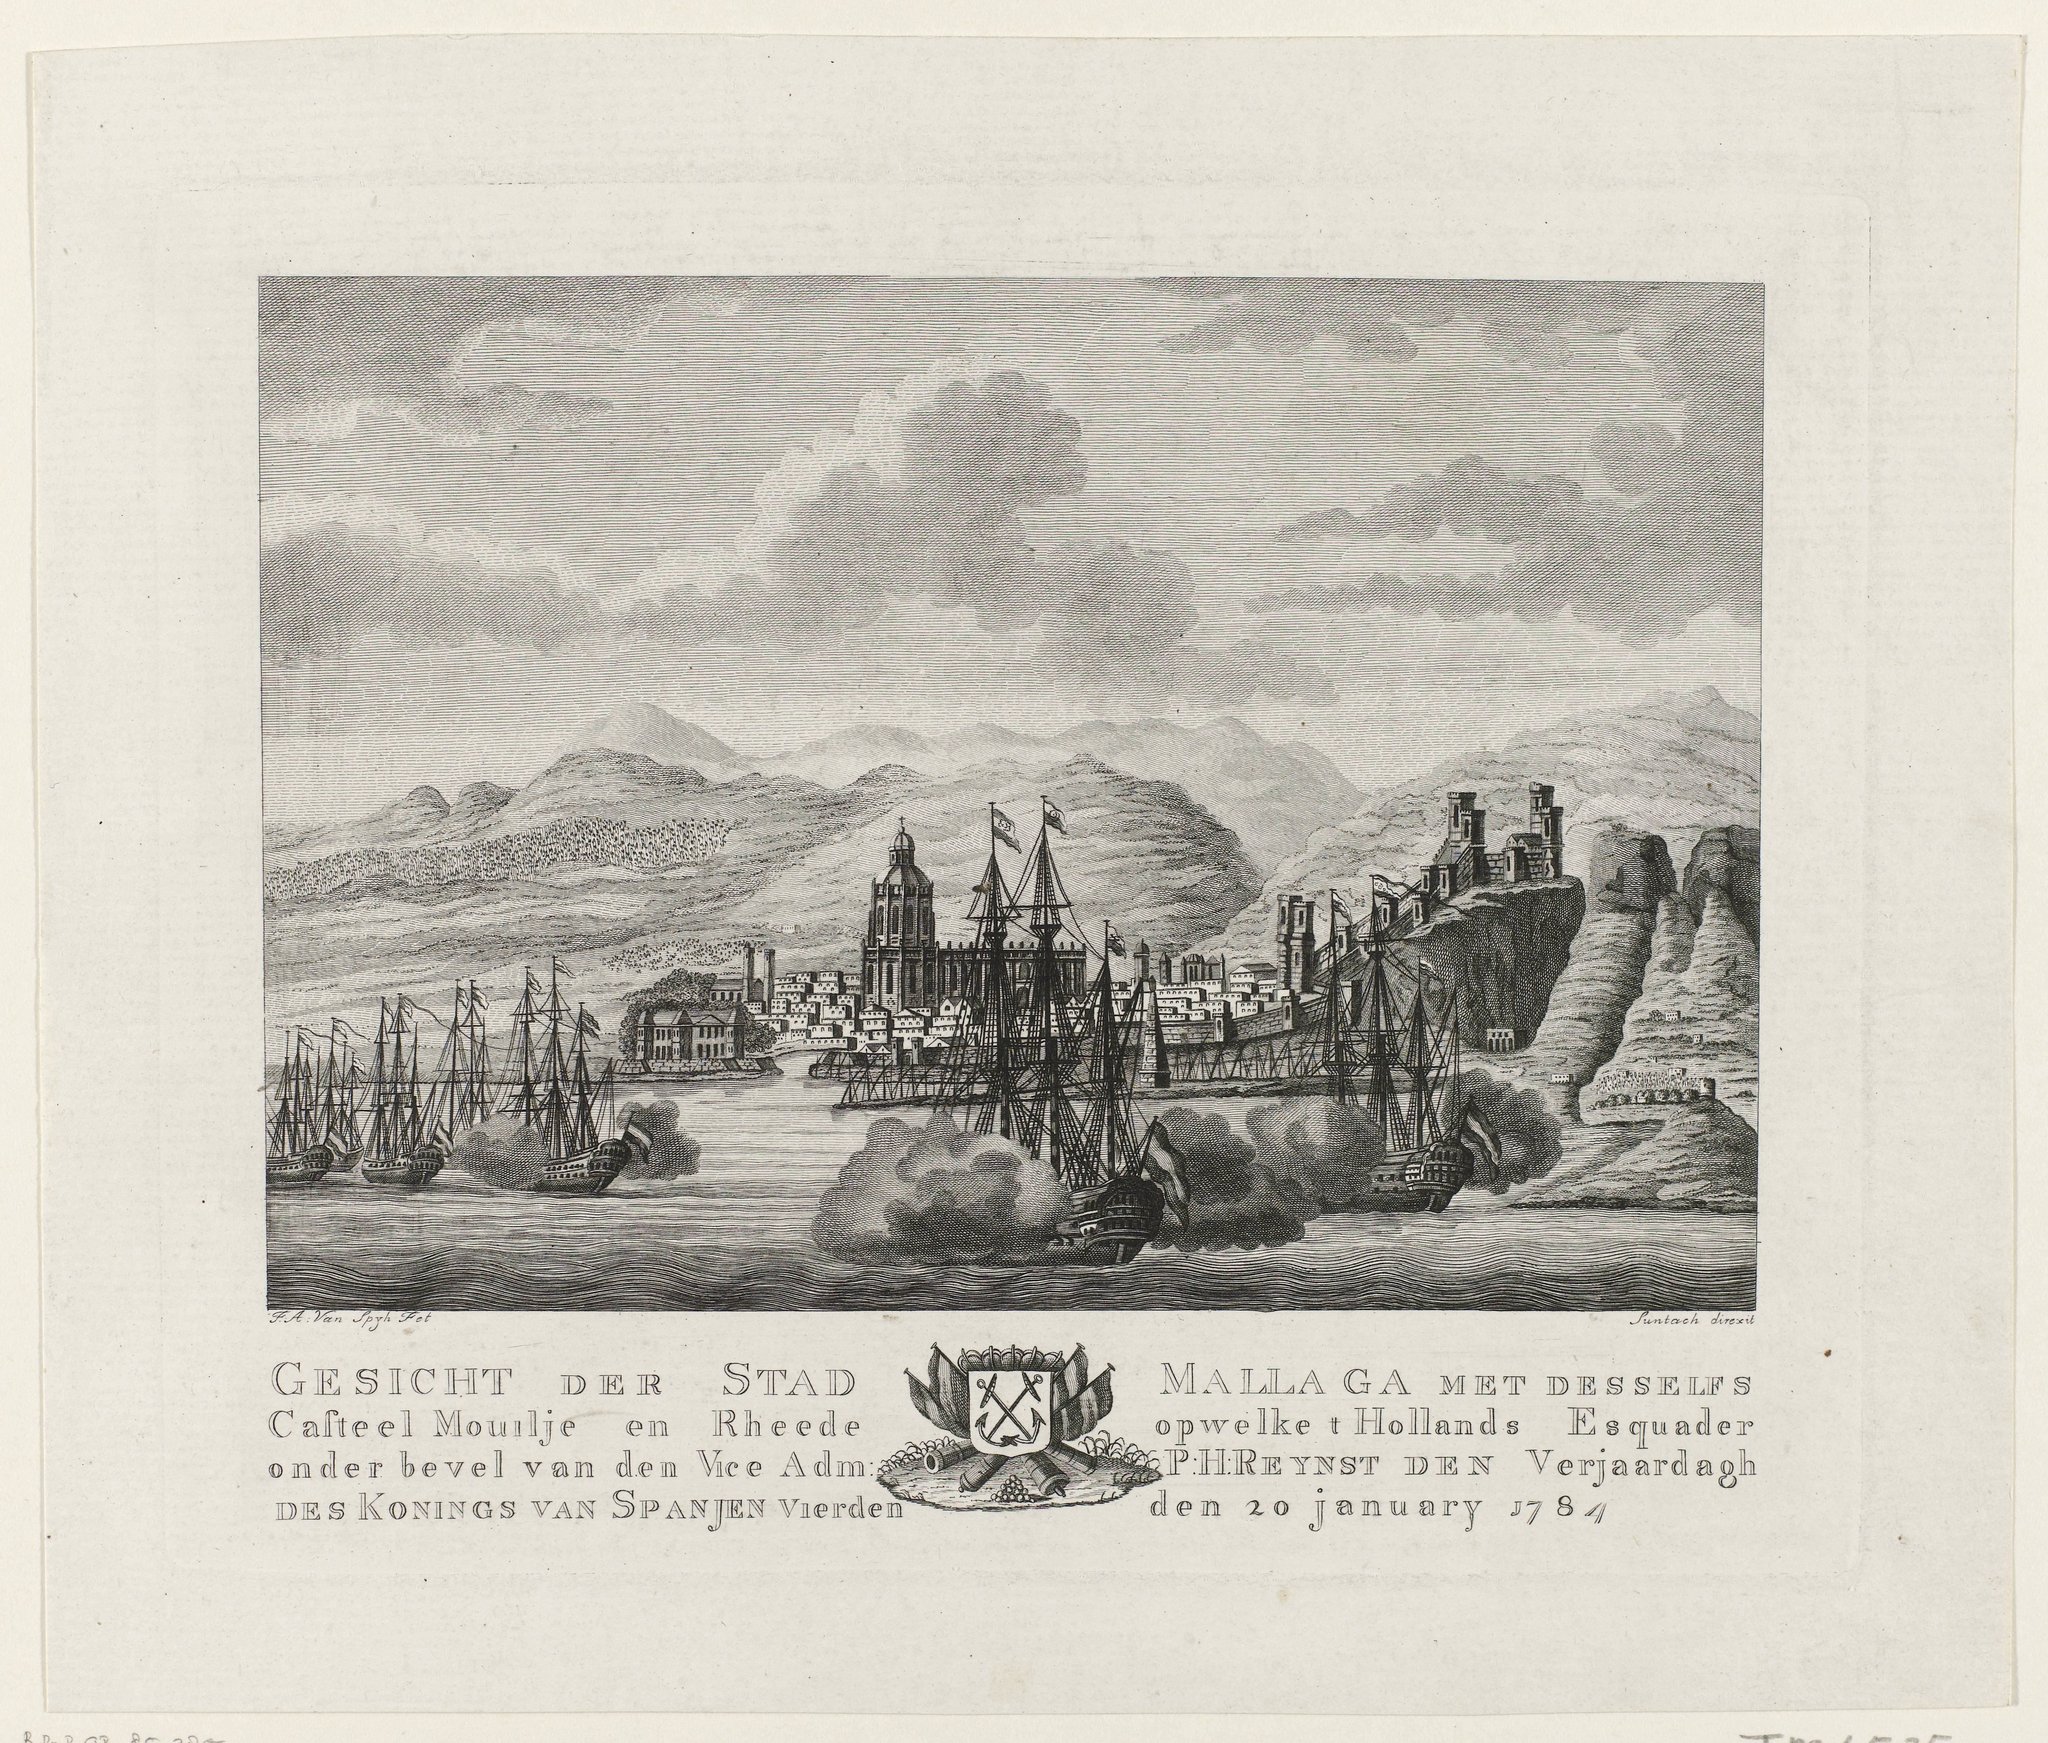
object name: print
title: Nederlandse vloot voor Malaga, 1784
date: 1784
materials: paper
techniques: engraving, etching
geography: northern netherlands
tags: arnhem, pieter hendrik reynst, karel iii (koning van spanje (1716-1788), cannon shots (military salute) (+ sailing-ships), warfare; military affairs (+ sailing-ships)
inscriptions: collector's mark: Lugt 2228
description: De Nederlandse oorlogsvloot onder vice-admiraal Pieter Hendrik Reynst op de rede van Malaga voor de viering van de verjaardag van Karel III, koning van Spanje, 20 januari 1784. Enkele oorlogsschepen vuren saluutschoten af.